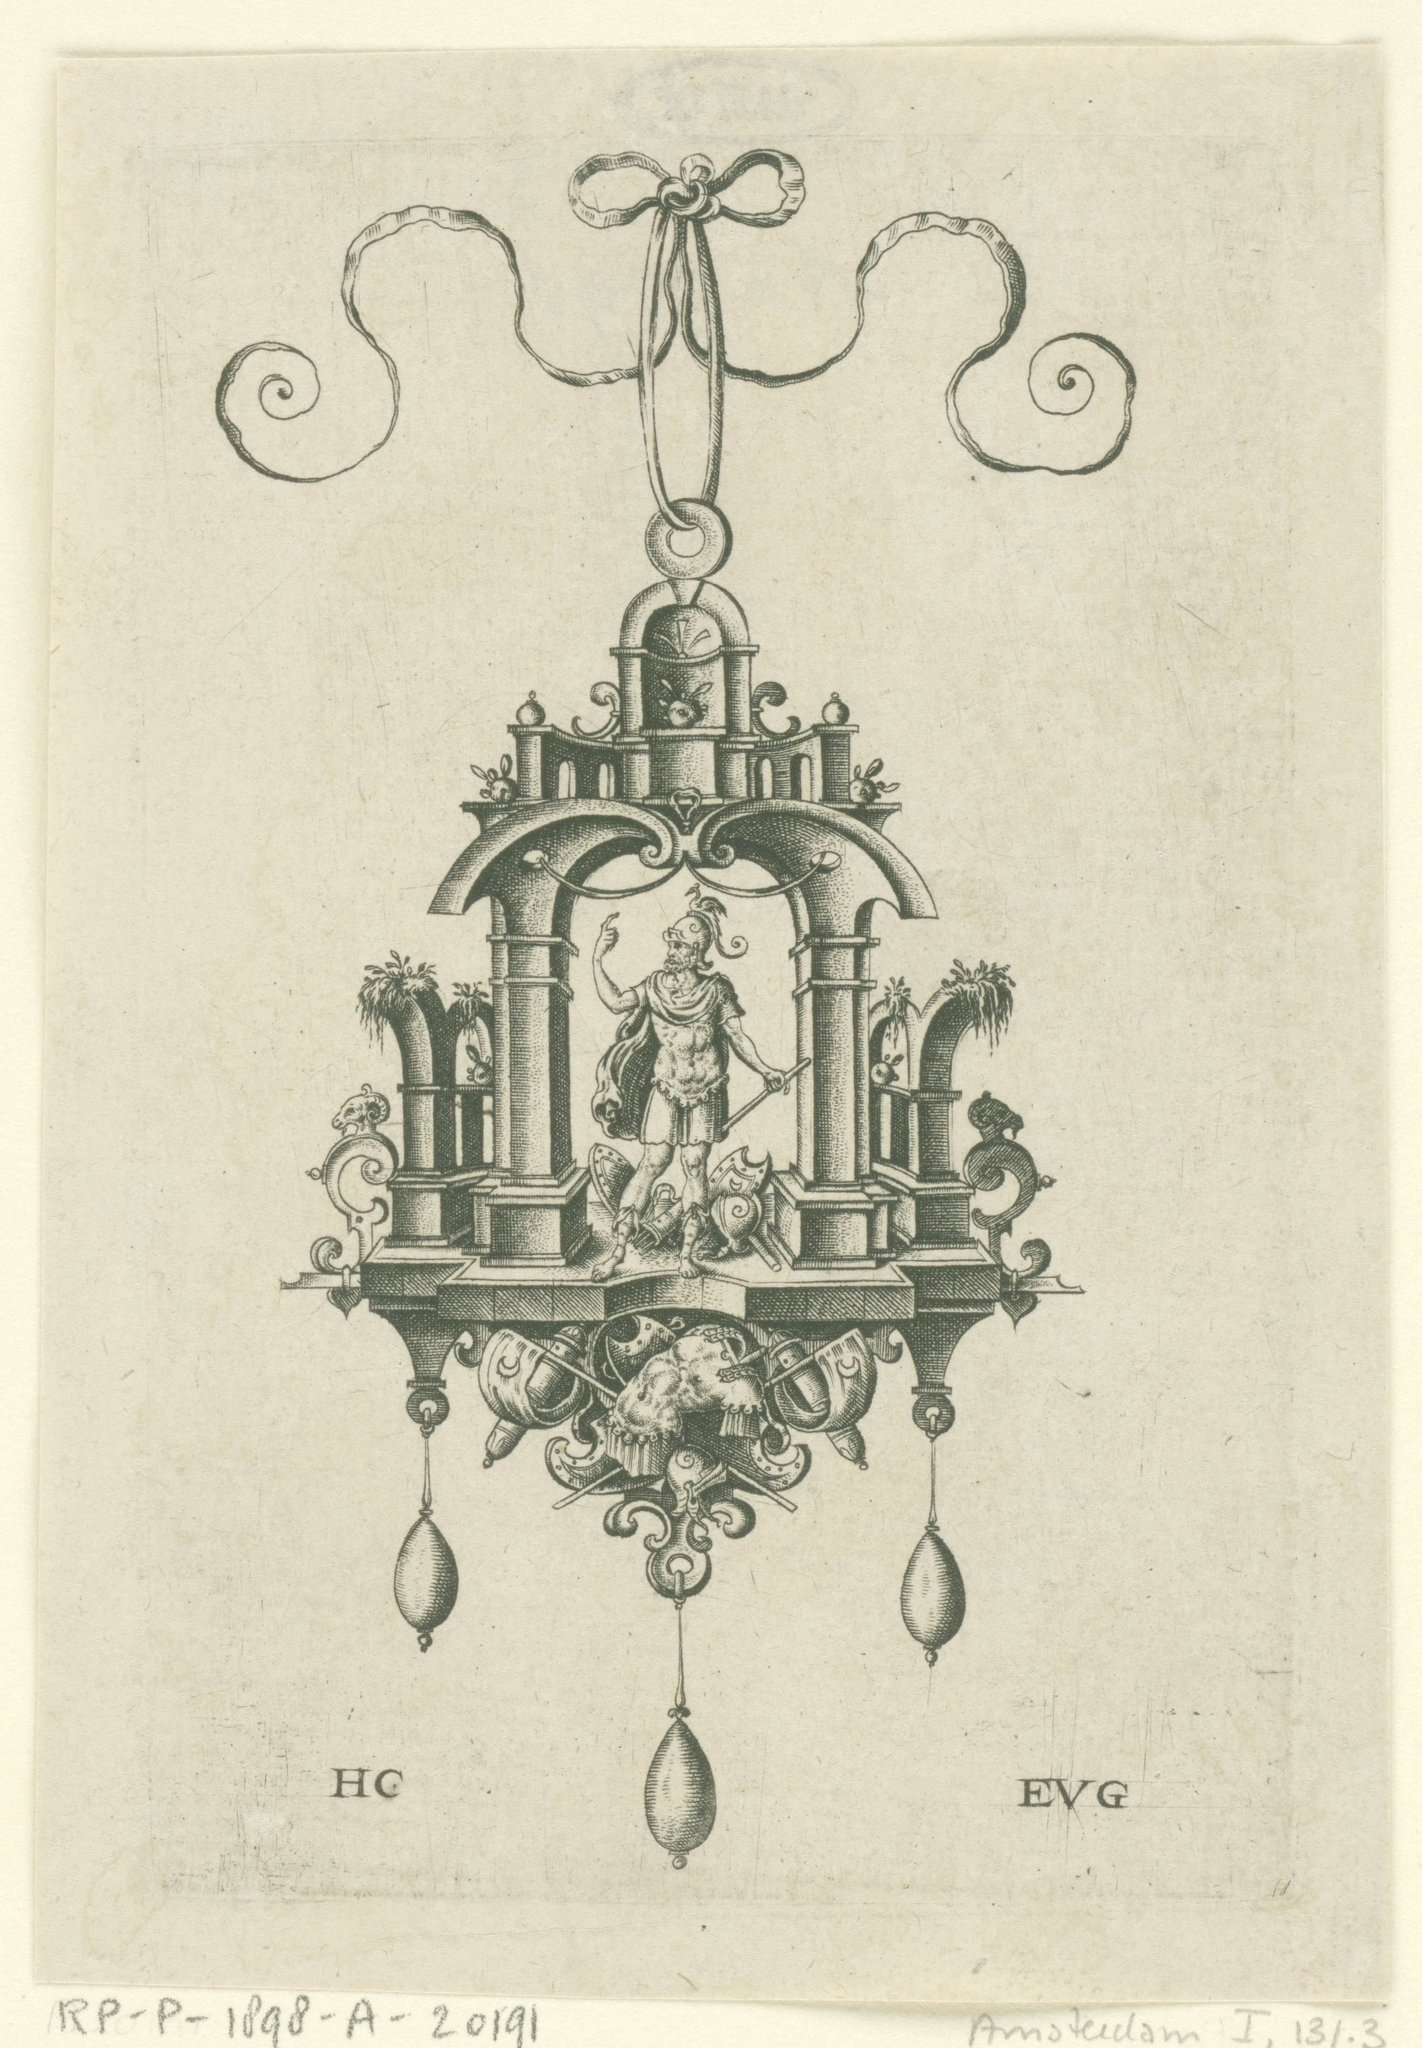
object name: ornament print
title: Hangers. Nissen, gedecoreerd met voluten van rol- en beslagwerk, mascarons, dieren en grotesken.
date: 1555-1576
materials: paper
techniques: engraving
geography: netherlands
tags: (story of) mars (ares), pendant, trinket, 'breloque'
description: Eén van 9 bladen, uit een serie van 12. Op zes bladen zit in de nis een figuur. Aan elke hanger hangen drie parels.